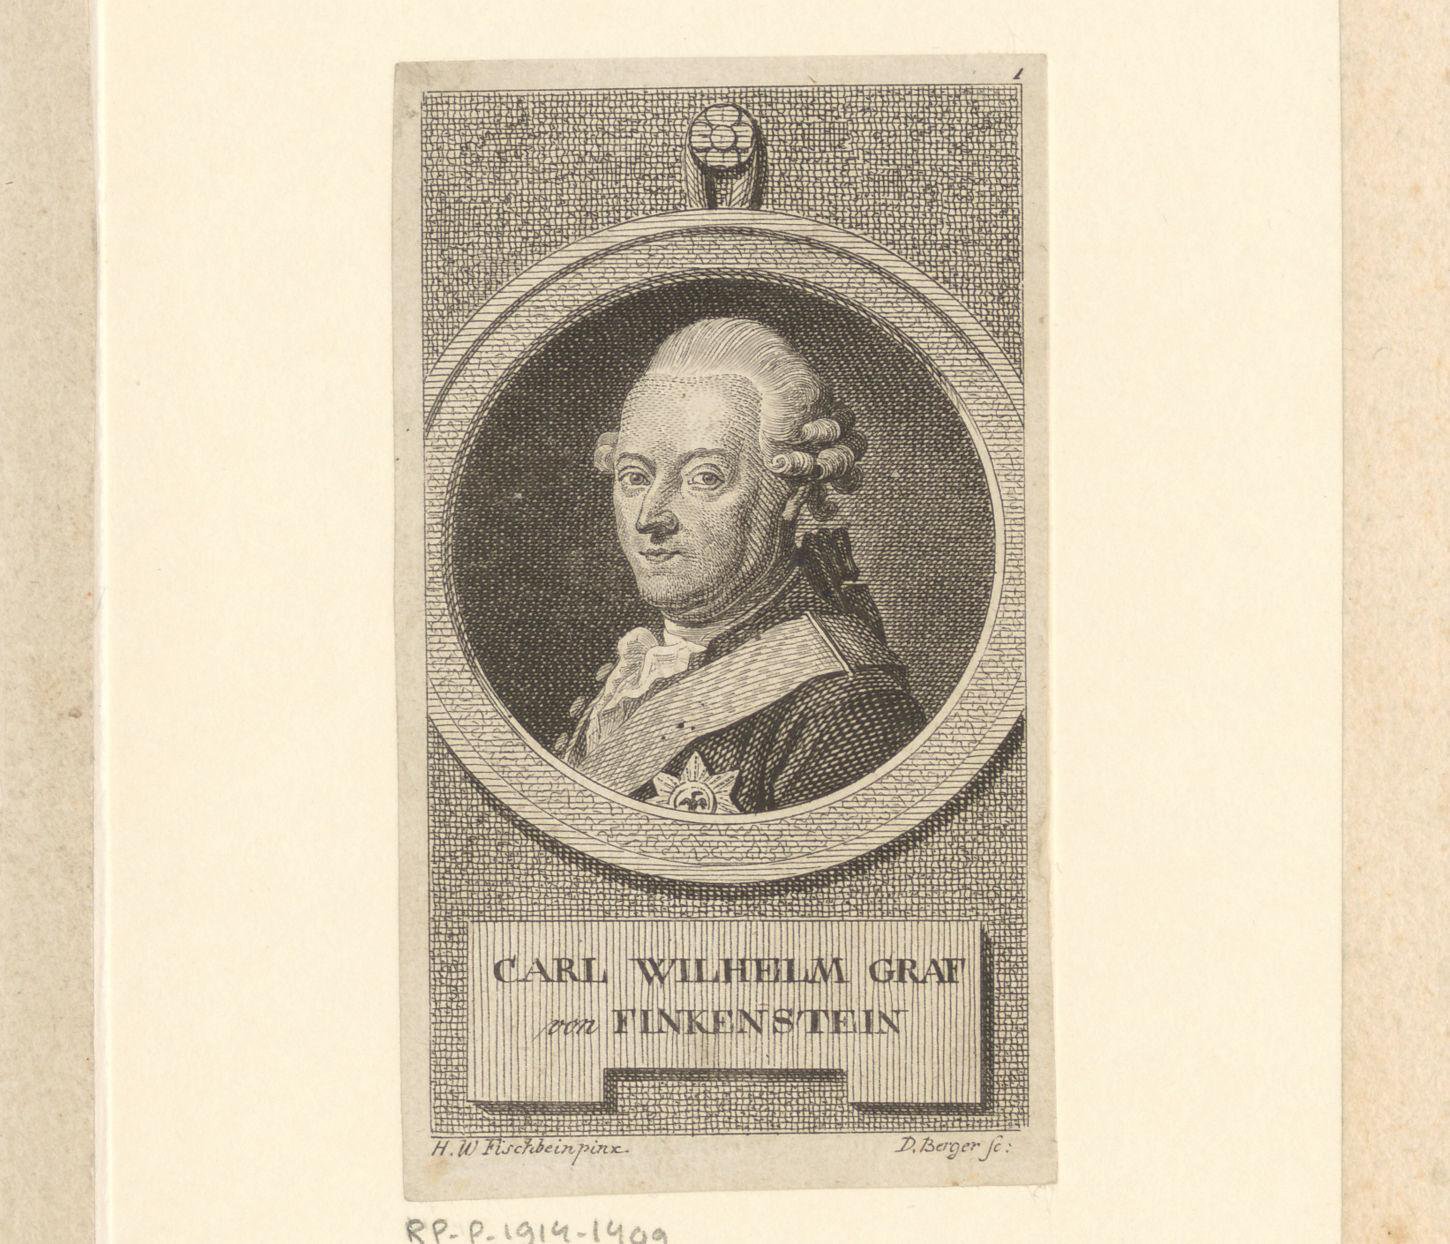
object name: book illustration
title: Portret van Carl Wilhelm Finck von Finckenstein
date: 1791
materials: paper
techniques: engraving, etching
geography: berlin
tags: historical persons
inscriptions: collector's mark: Lugt 2228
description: Prent afkomstig uit: Historisch-Genealogischer Calender auf das Jahr 1792. Berlijn: Haude & Spener, [1791]. Dit is de eerste prent uit een serie van twaalf Pruisische ministers.